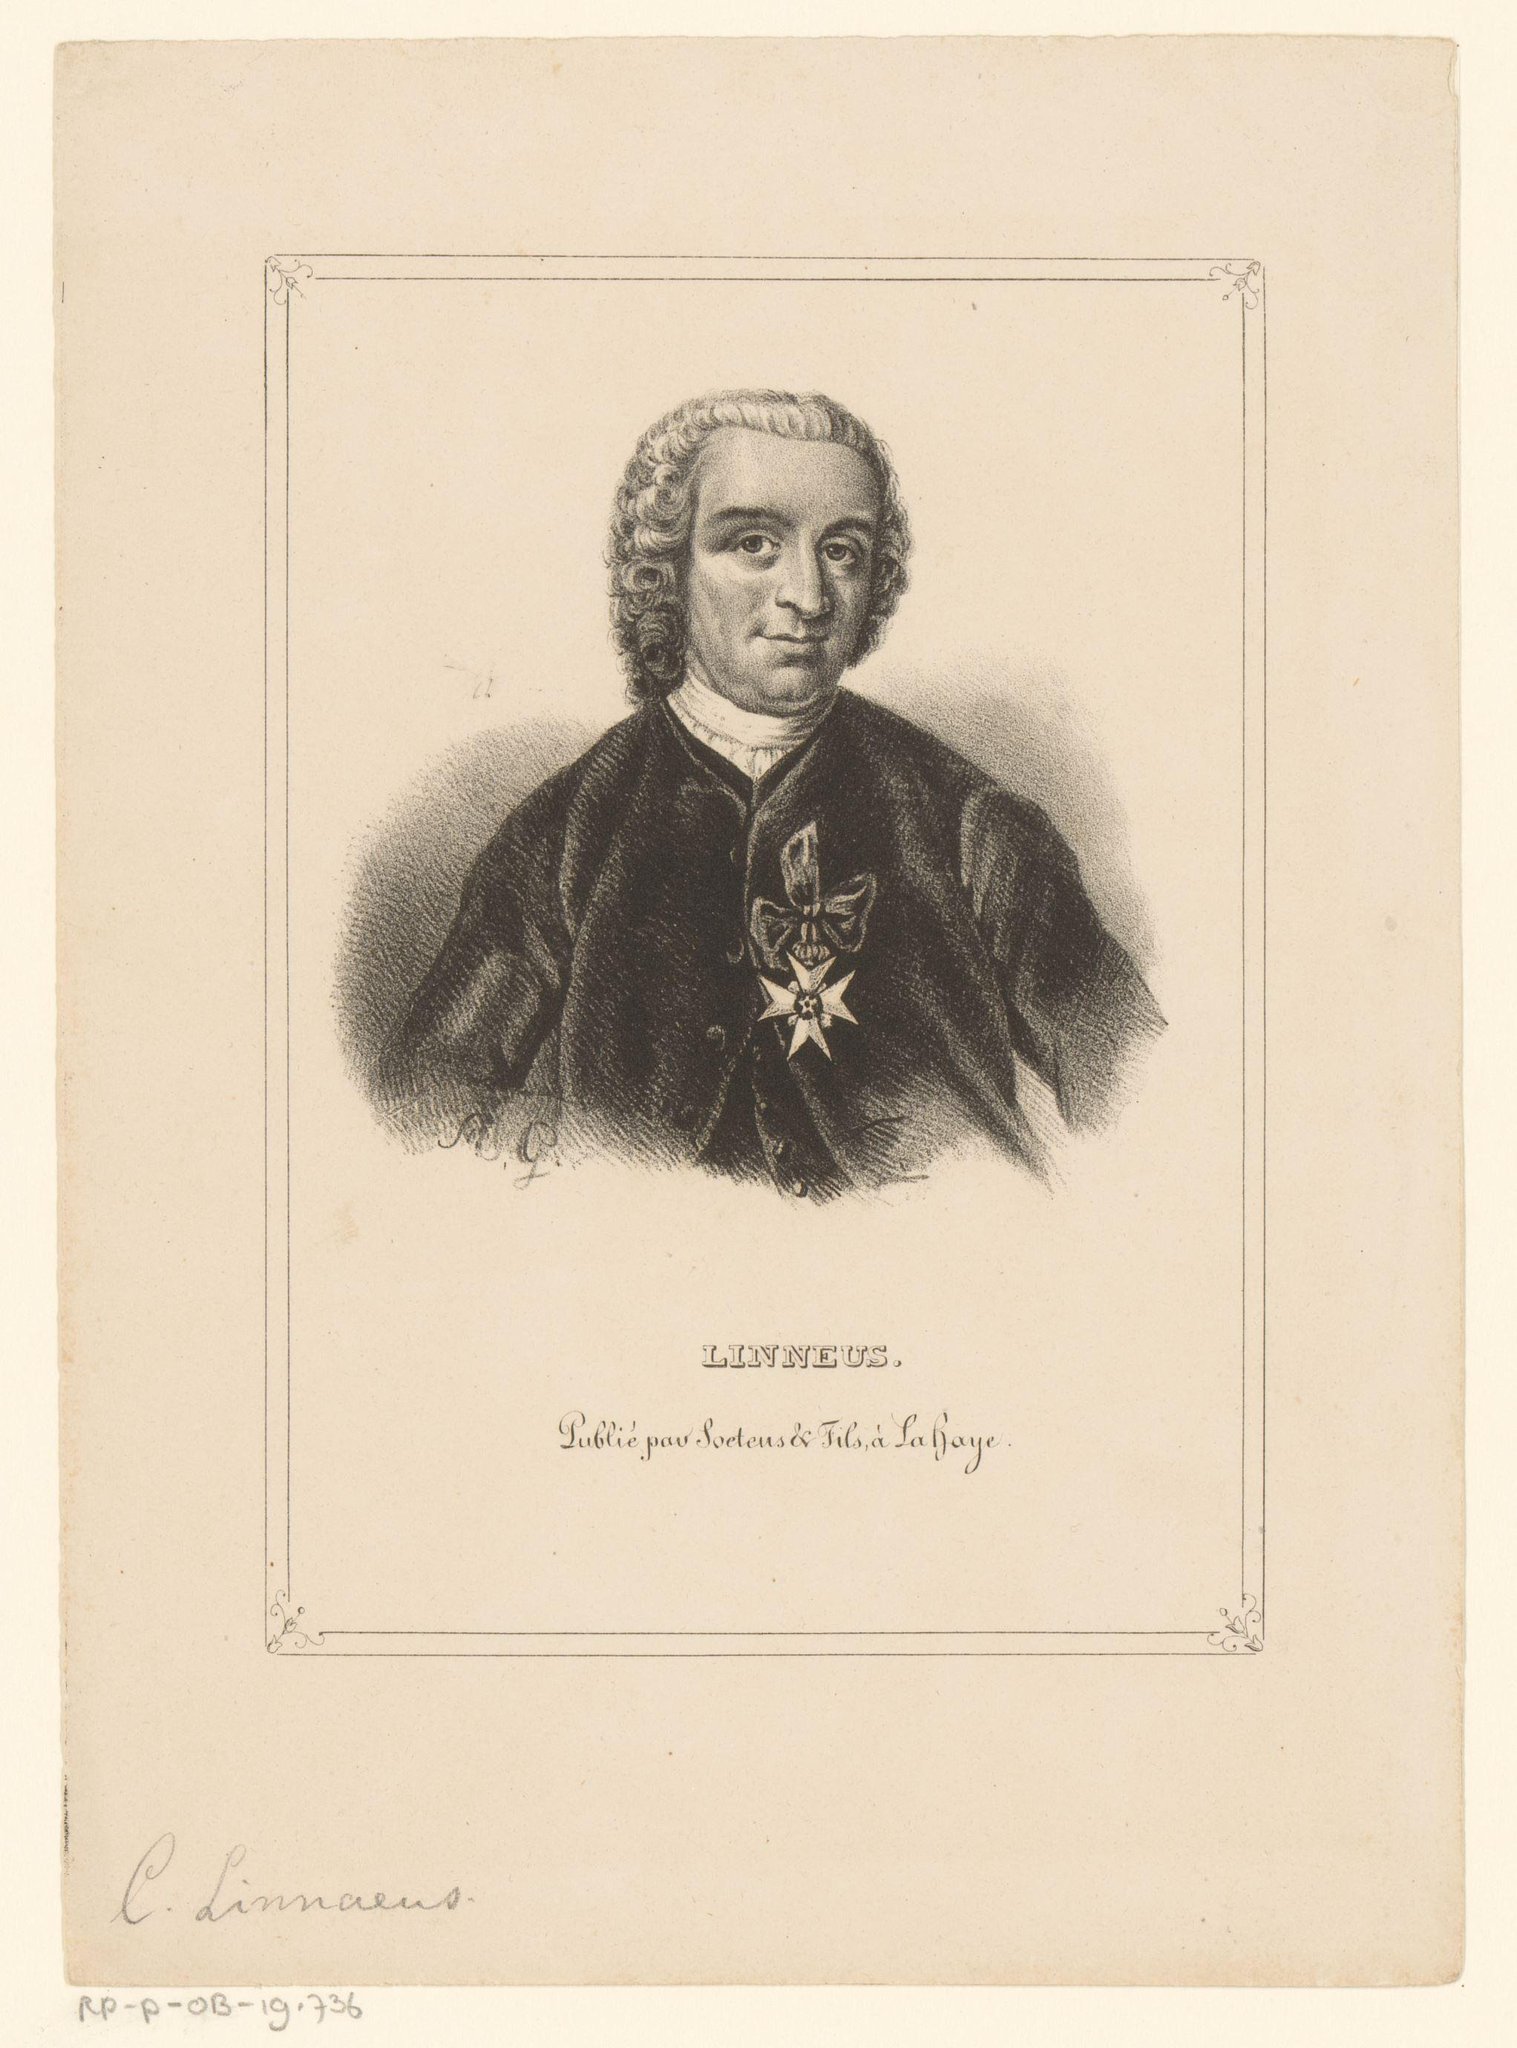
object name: print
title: Portret van Carl Linnaeus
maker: achille girardot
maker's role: draughtsman, painter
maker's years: 1814-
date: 1837-1840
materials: paper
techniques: lithograph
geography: the hague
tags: carl linnaeus, historical persons (+ (full) bust portrait)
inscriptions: monogram: ‘A.G.’, collector's mark: Lugt 2228